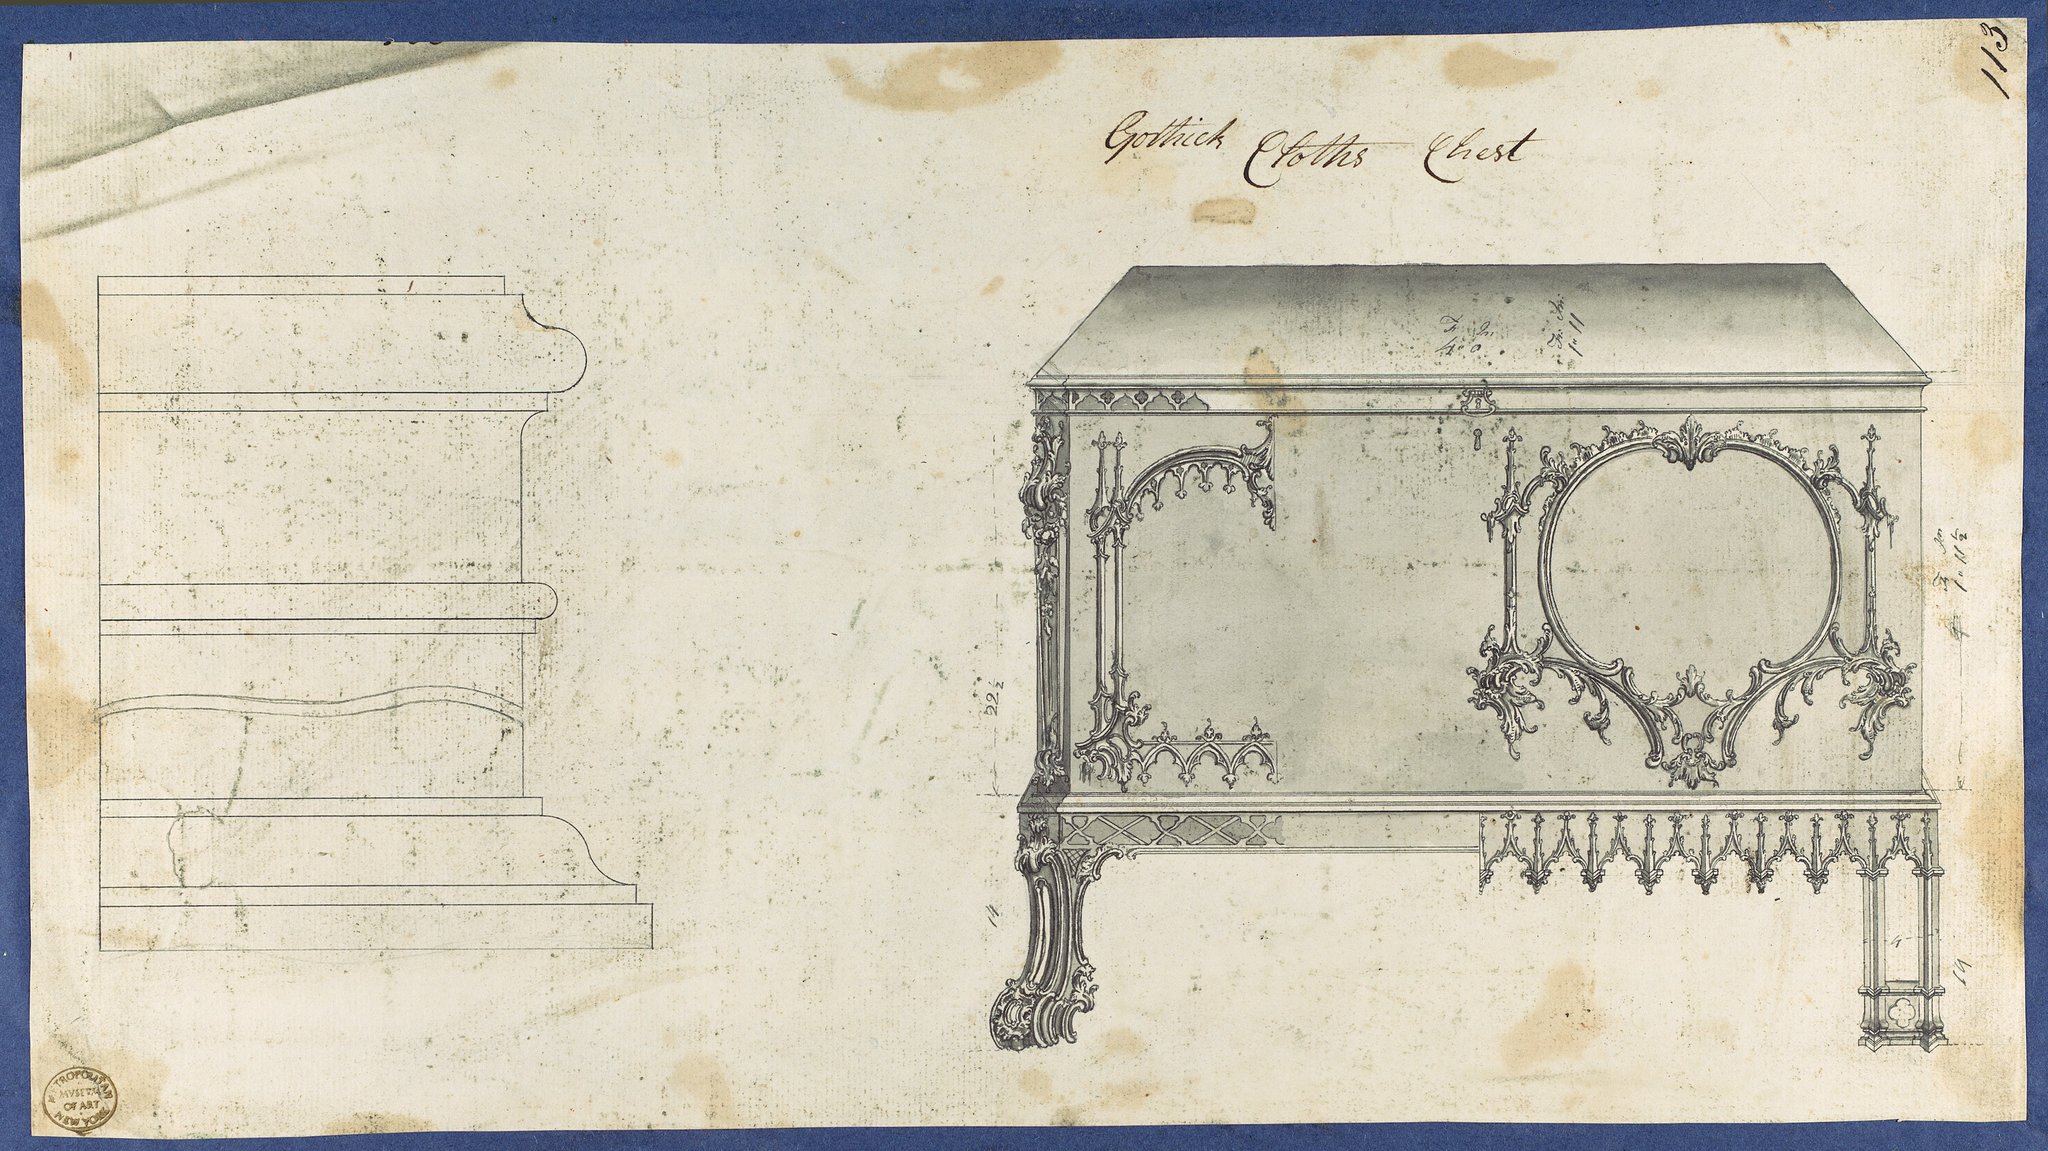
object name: drawing ornament architecture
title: Gothic Clothes Chest, from Chippendale Drawings, Vol. II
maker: thomas chippendale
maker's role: artist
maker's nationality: british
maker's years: 1718-1779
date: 1753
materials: ink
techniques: wash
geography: london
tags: ornament,chests